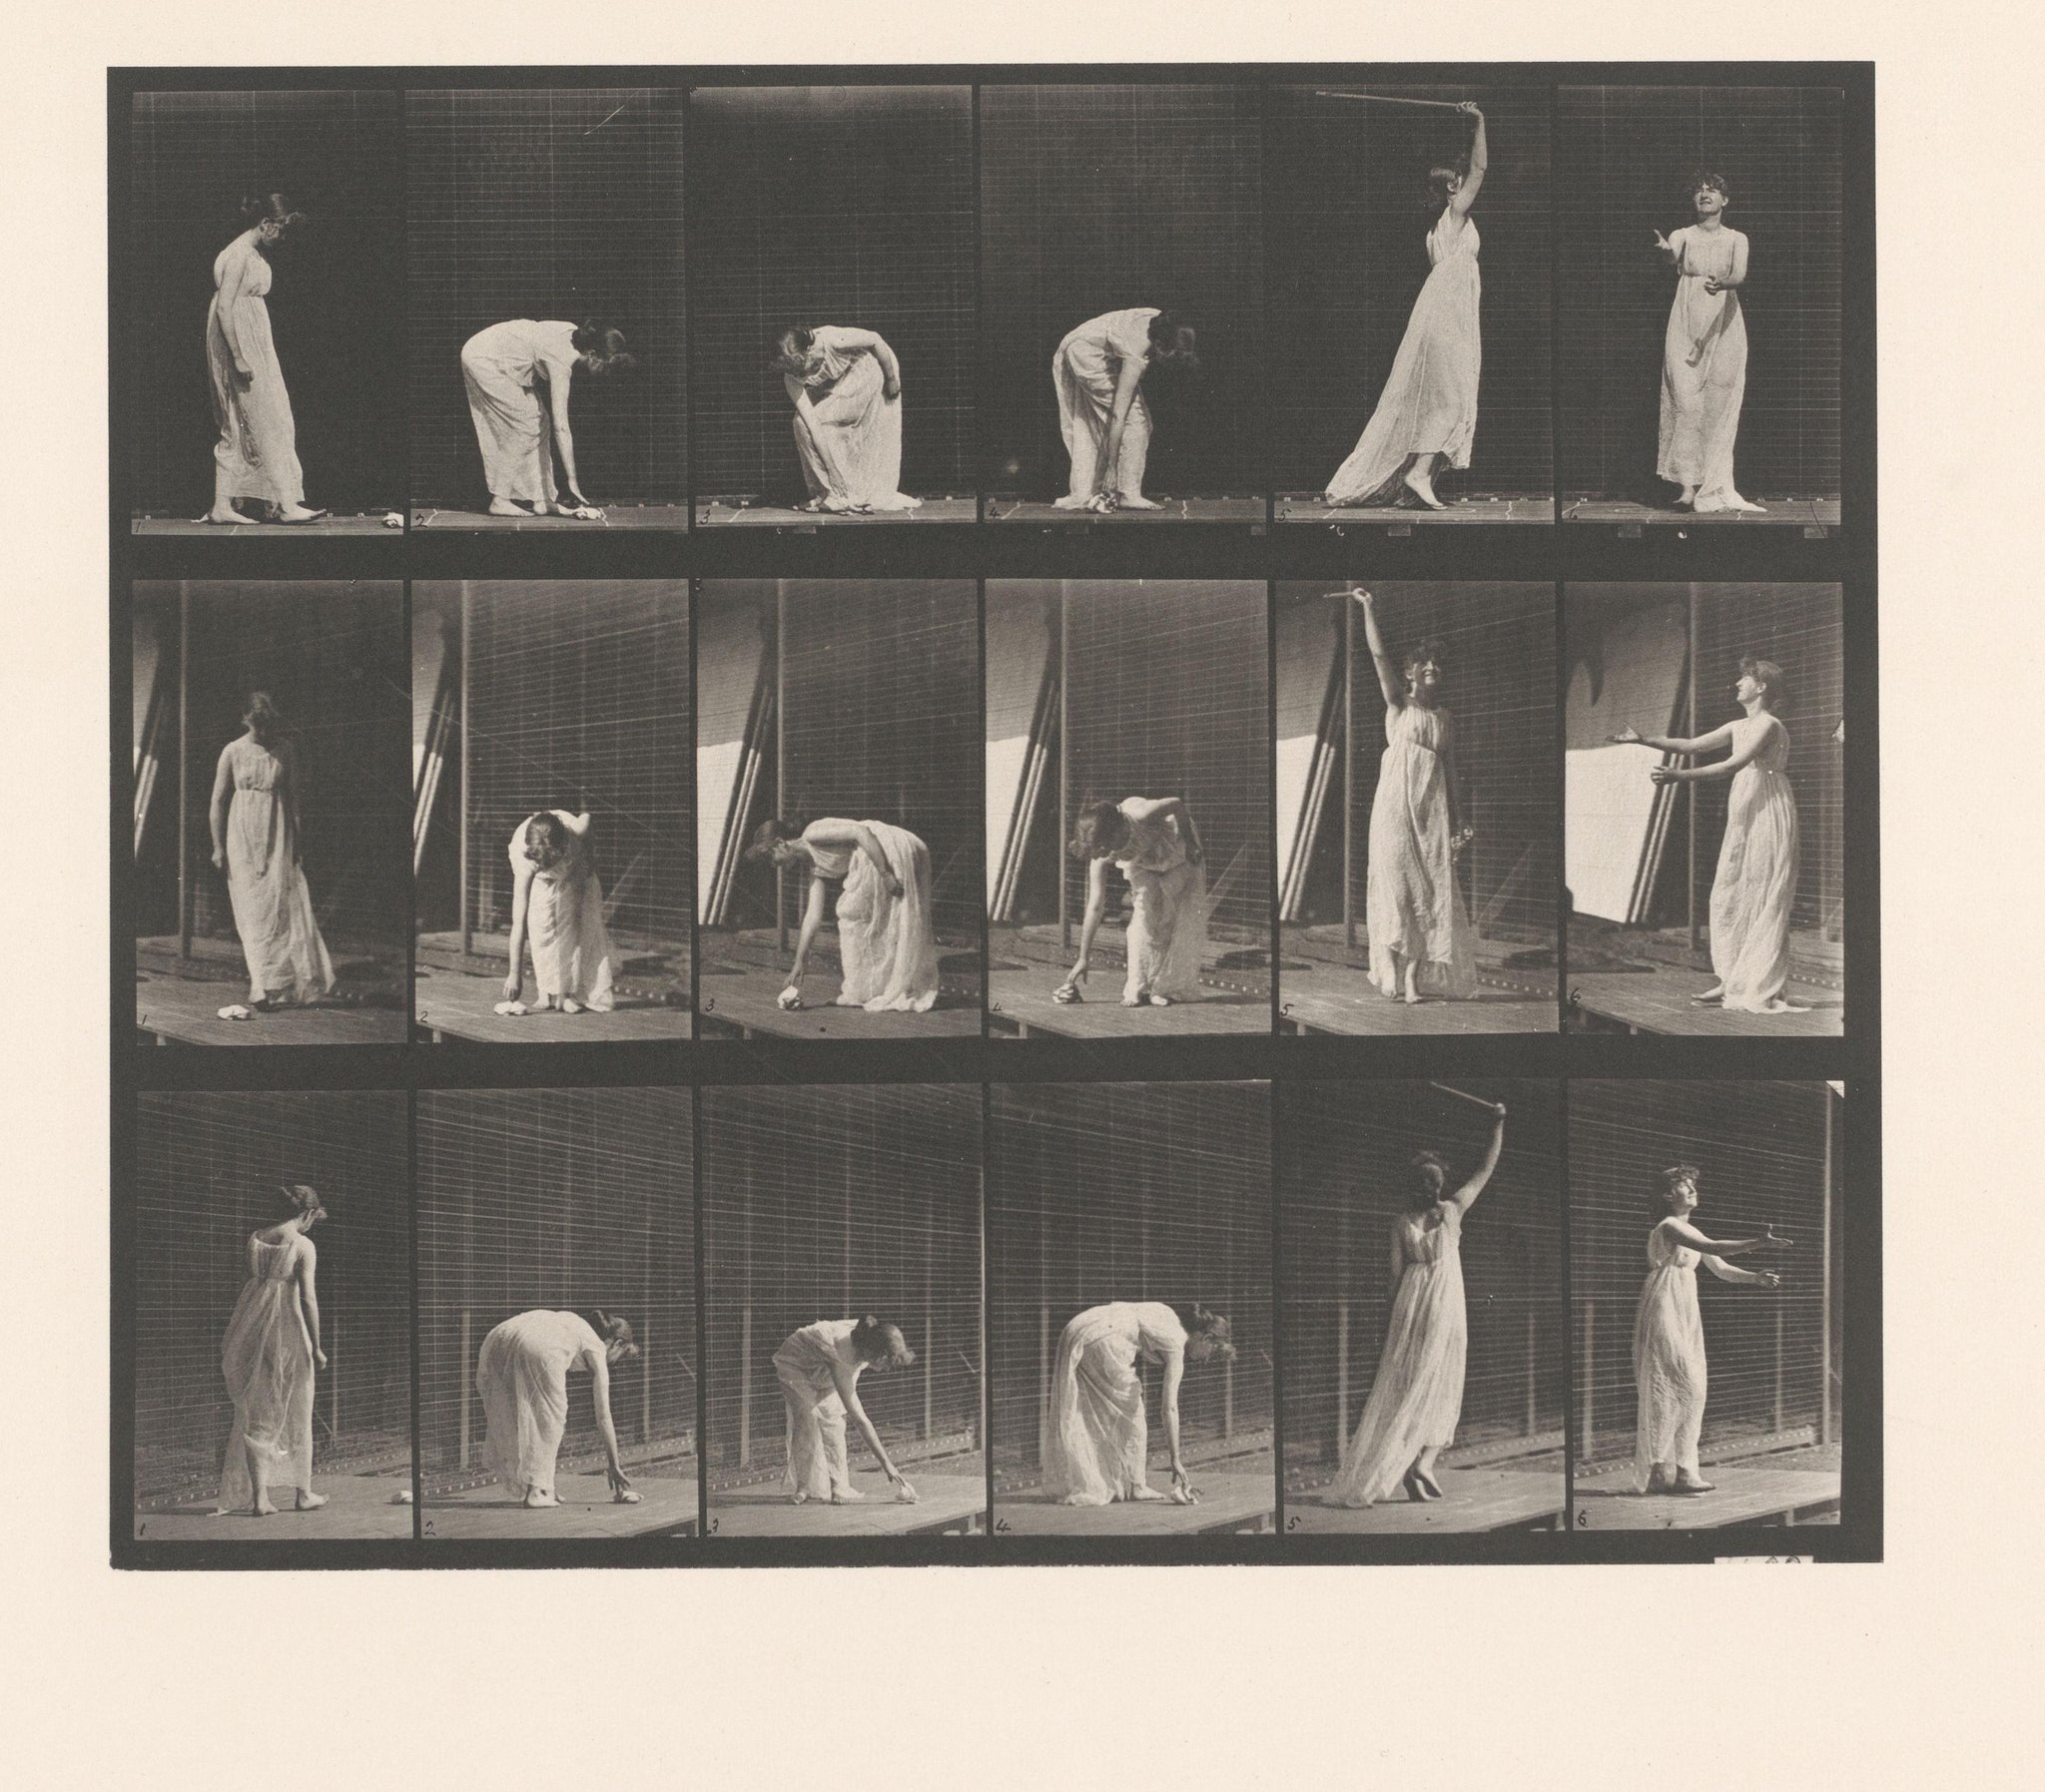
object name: photomechanical print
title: Woman Moving, 'Miscellaneous - stooping, etc'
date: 1887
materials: paper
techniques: photograph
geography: united states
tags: movements of the human body, historical persons - bb - woman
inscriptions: number: ‘PLATE 503’, copyright notice: ‘Copyright 1887, by EADWARD MUYBRIDGE. All rights reserved.’, number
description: Afkomstig uit: Animal locomotion: an electro-photographic investigation of consecutive phases of animal movements, 1872-1885.